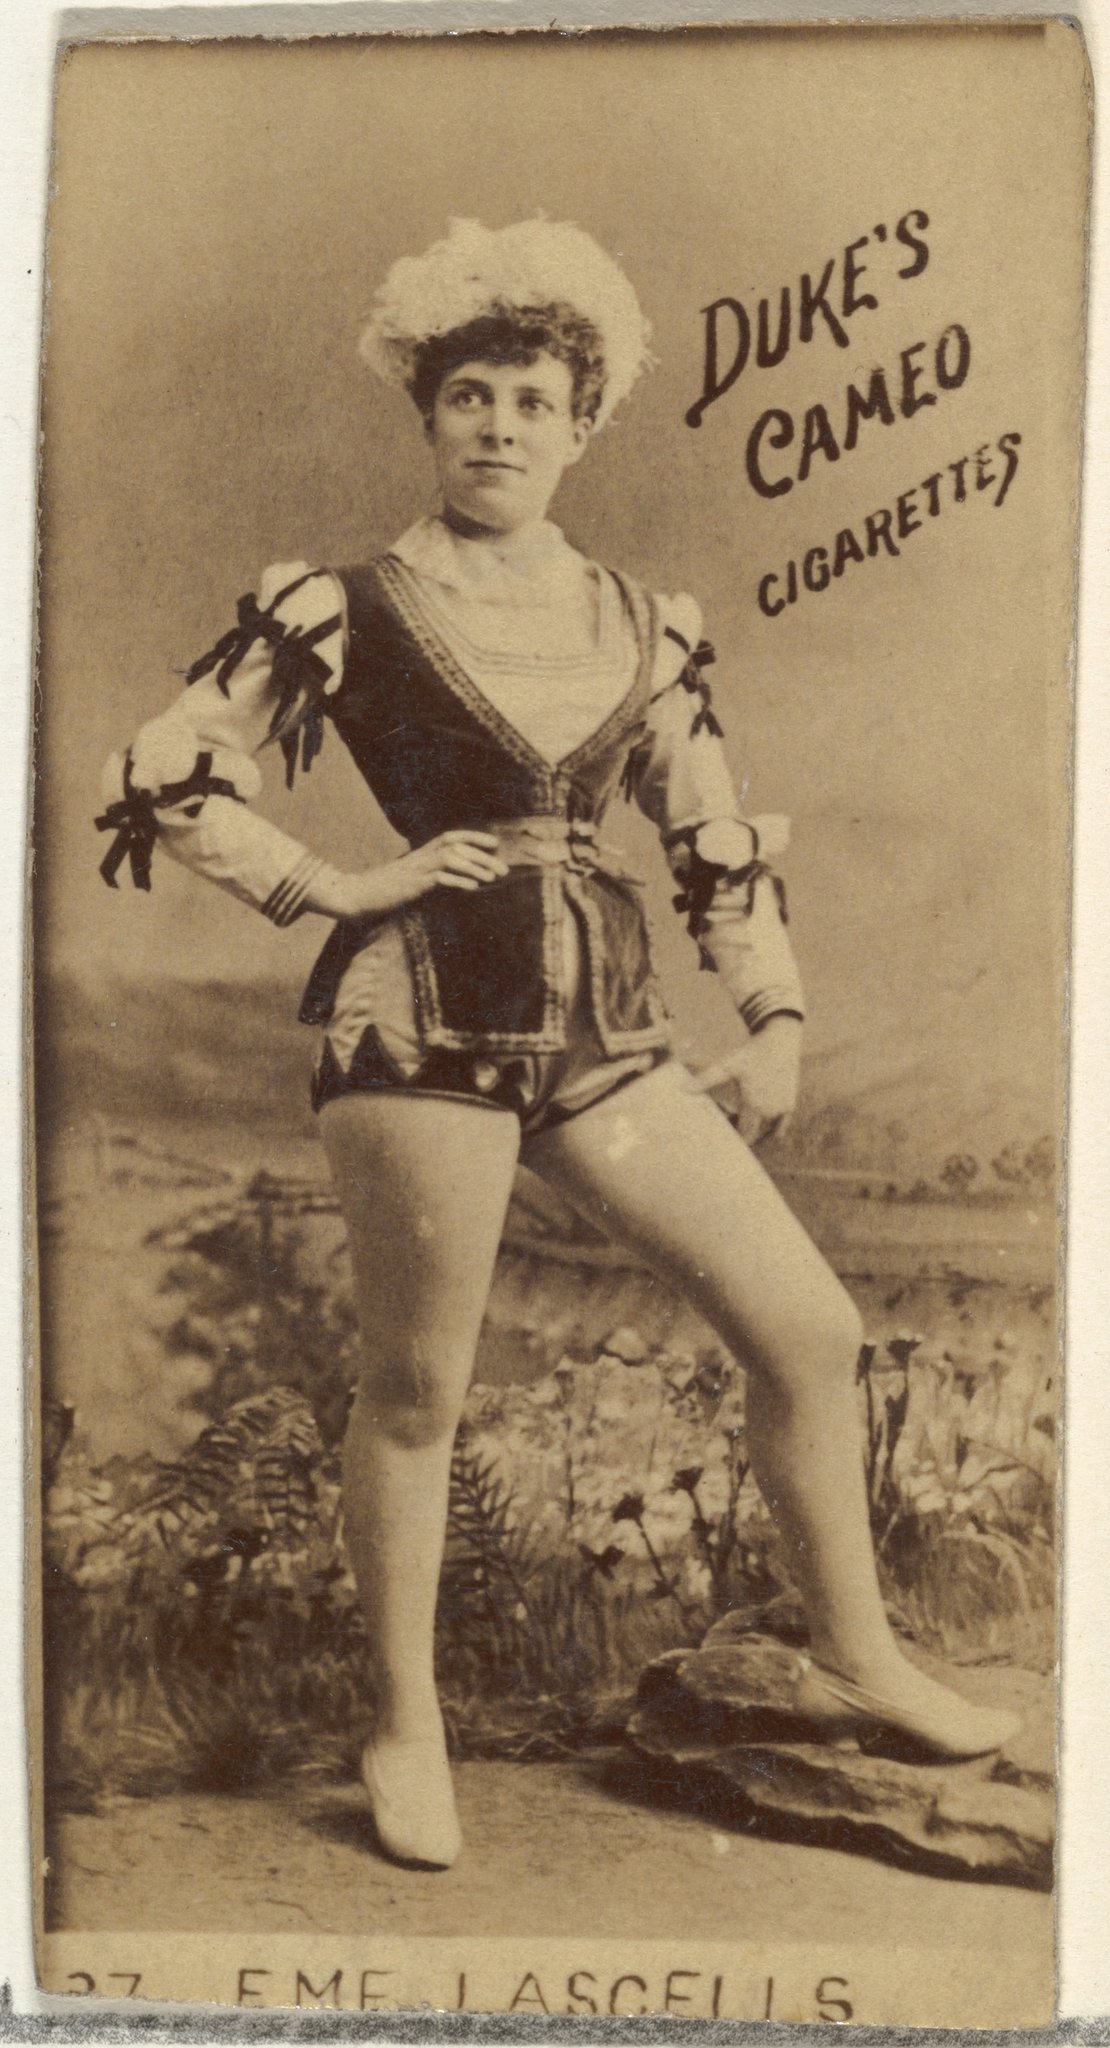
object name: photograph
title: Eme Lascells, from the Actors and Actresses series (N145-4) issued by Duke Sons & Co. to promote Cameo Cigarettes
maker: w. duke, sons & co.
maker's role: publisher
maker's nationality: american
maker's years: 1870-1920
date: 1880-1889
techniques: albumen silver print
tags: portraits,women,actresses